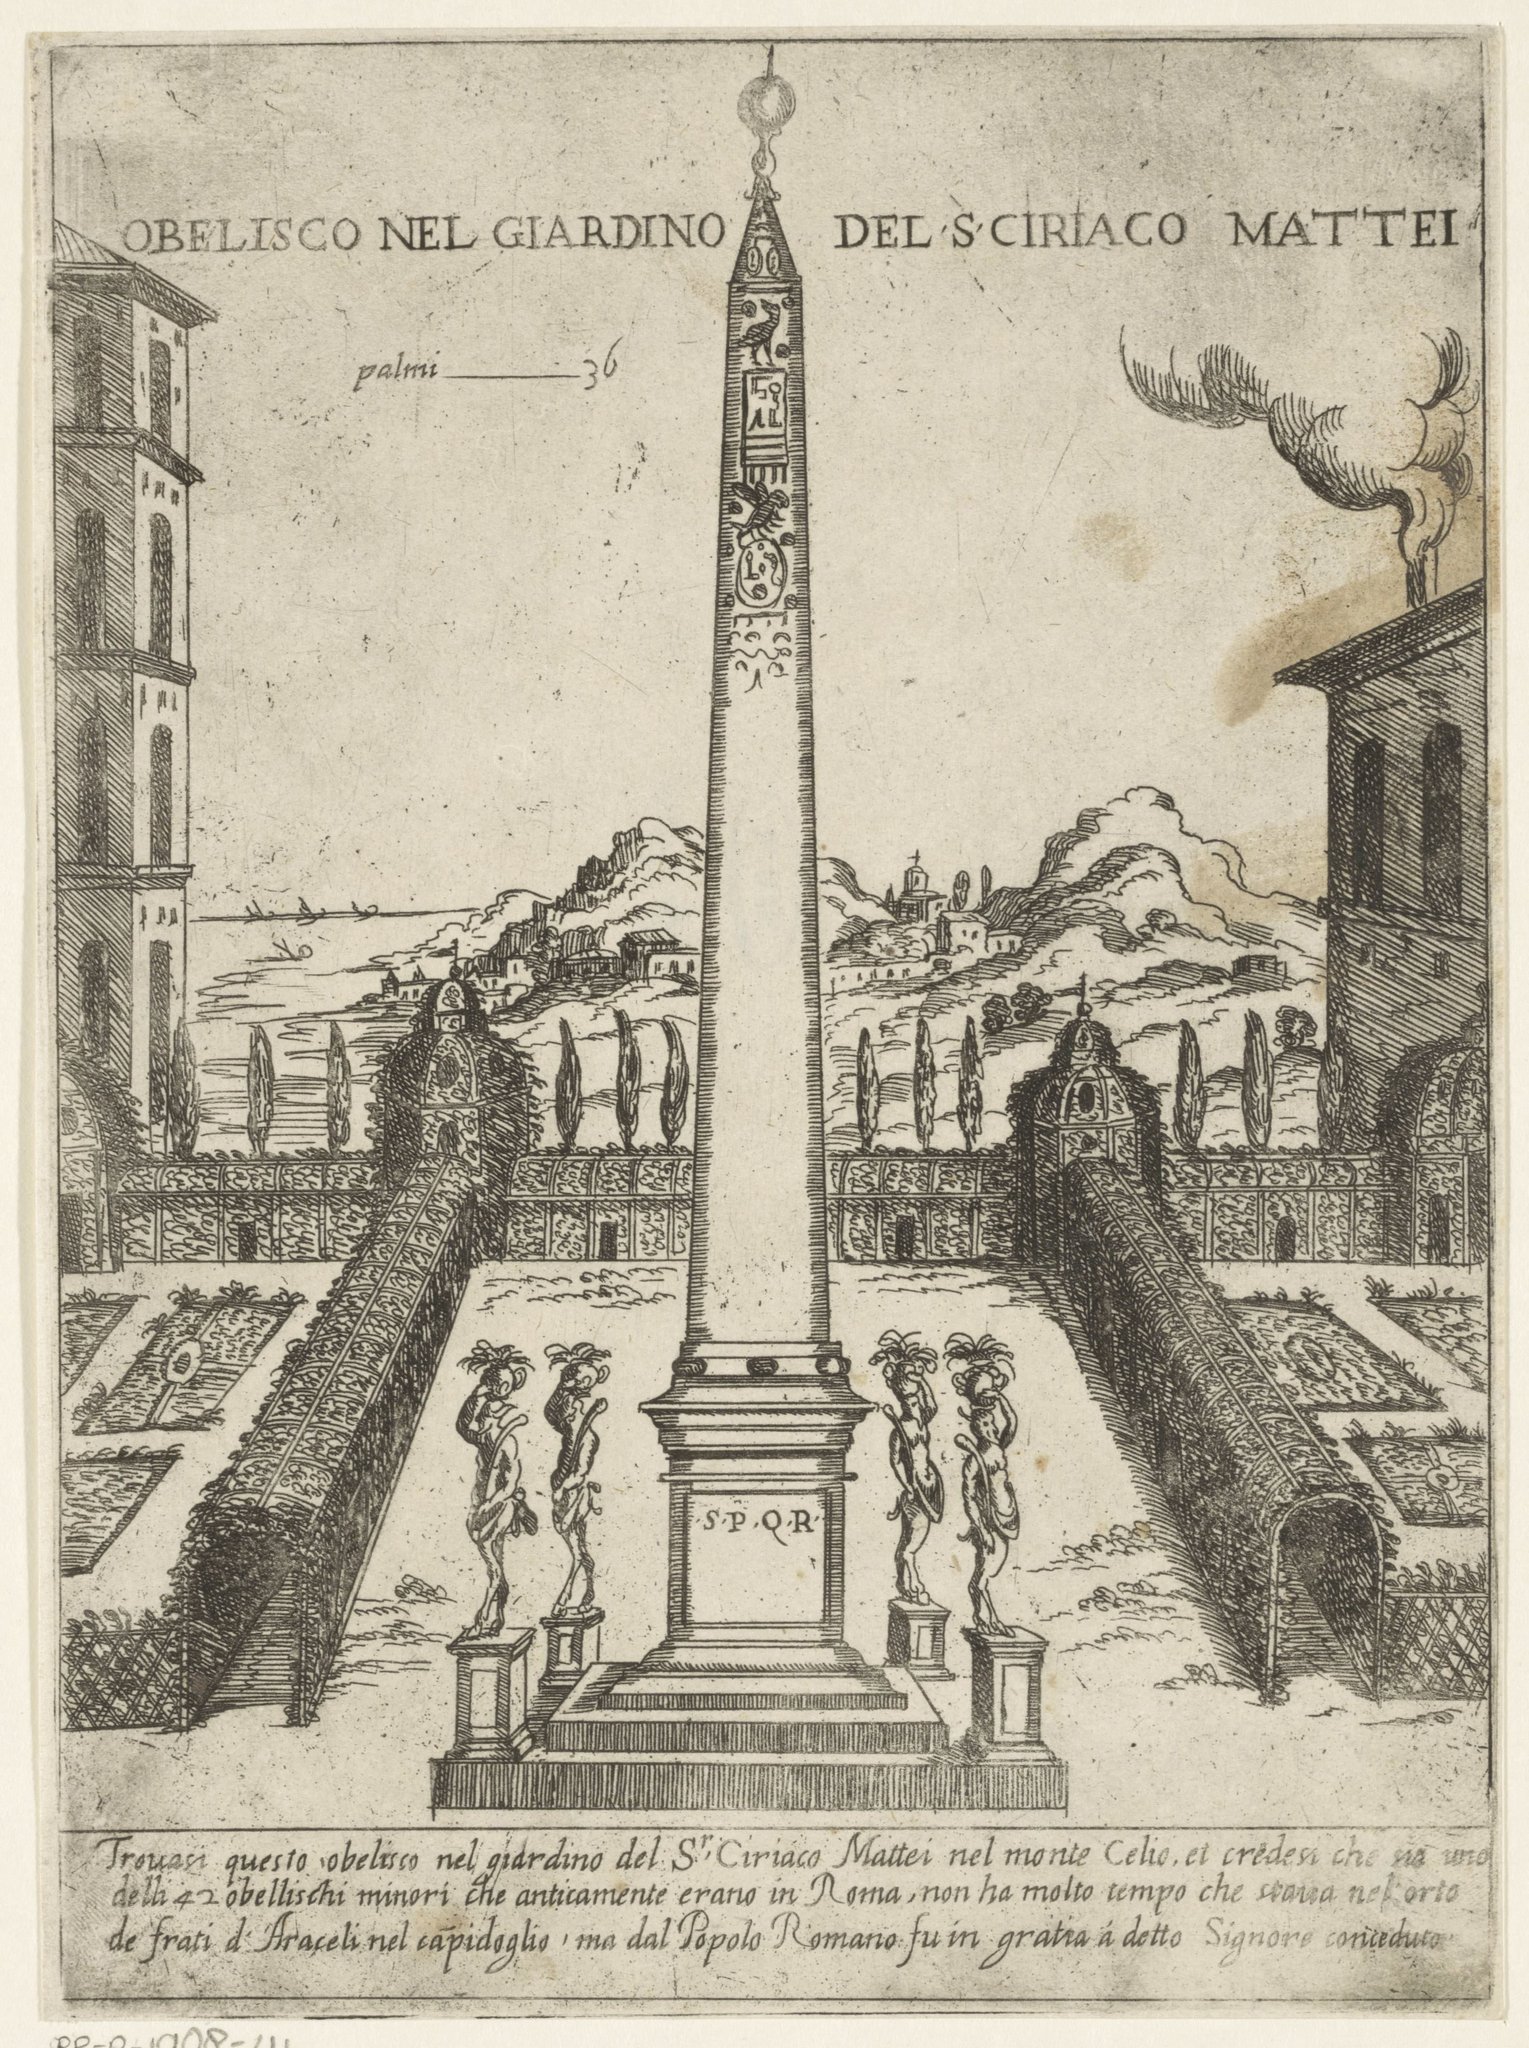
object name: print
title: Moderne en antieke monumenten en bouwwerken in Rome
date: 1576-1618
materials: paper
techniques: etching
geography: rome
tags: obelisk, needle, garden, rome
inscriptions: collector's mark: Lugt 1337, collector's mark: Lugt 2228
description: De Egyptische obelisk in de tuin van Ciriaco Mattei te Rome. Italiaanse tekst in ondermarge.